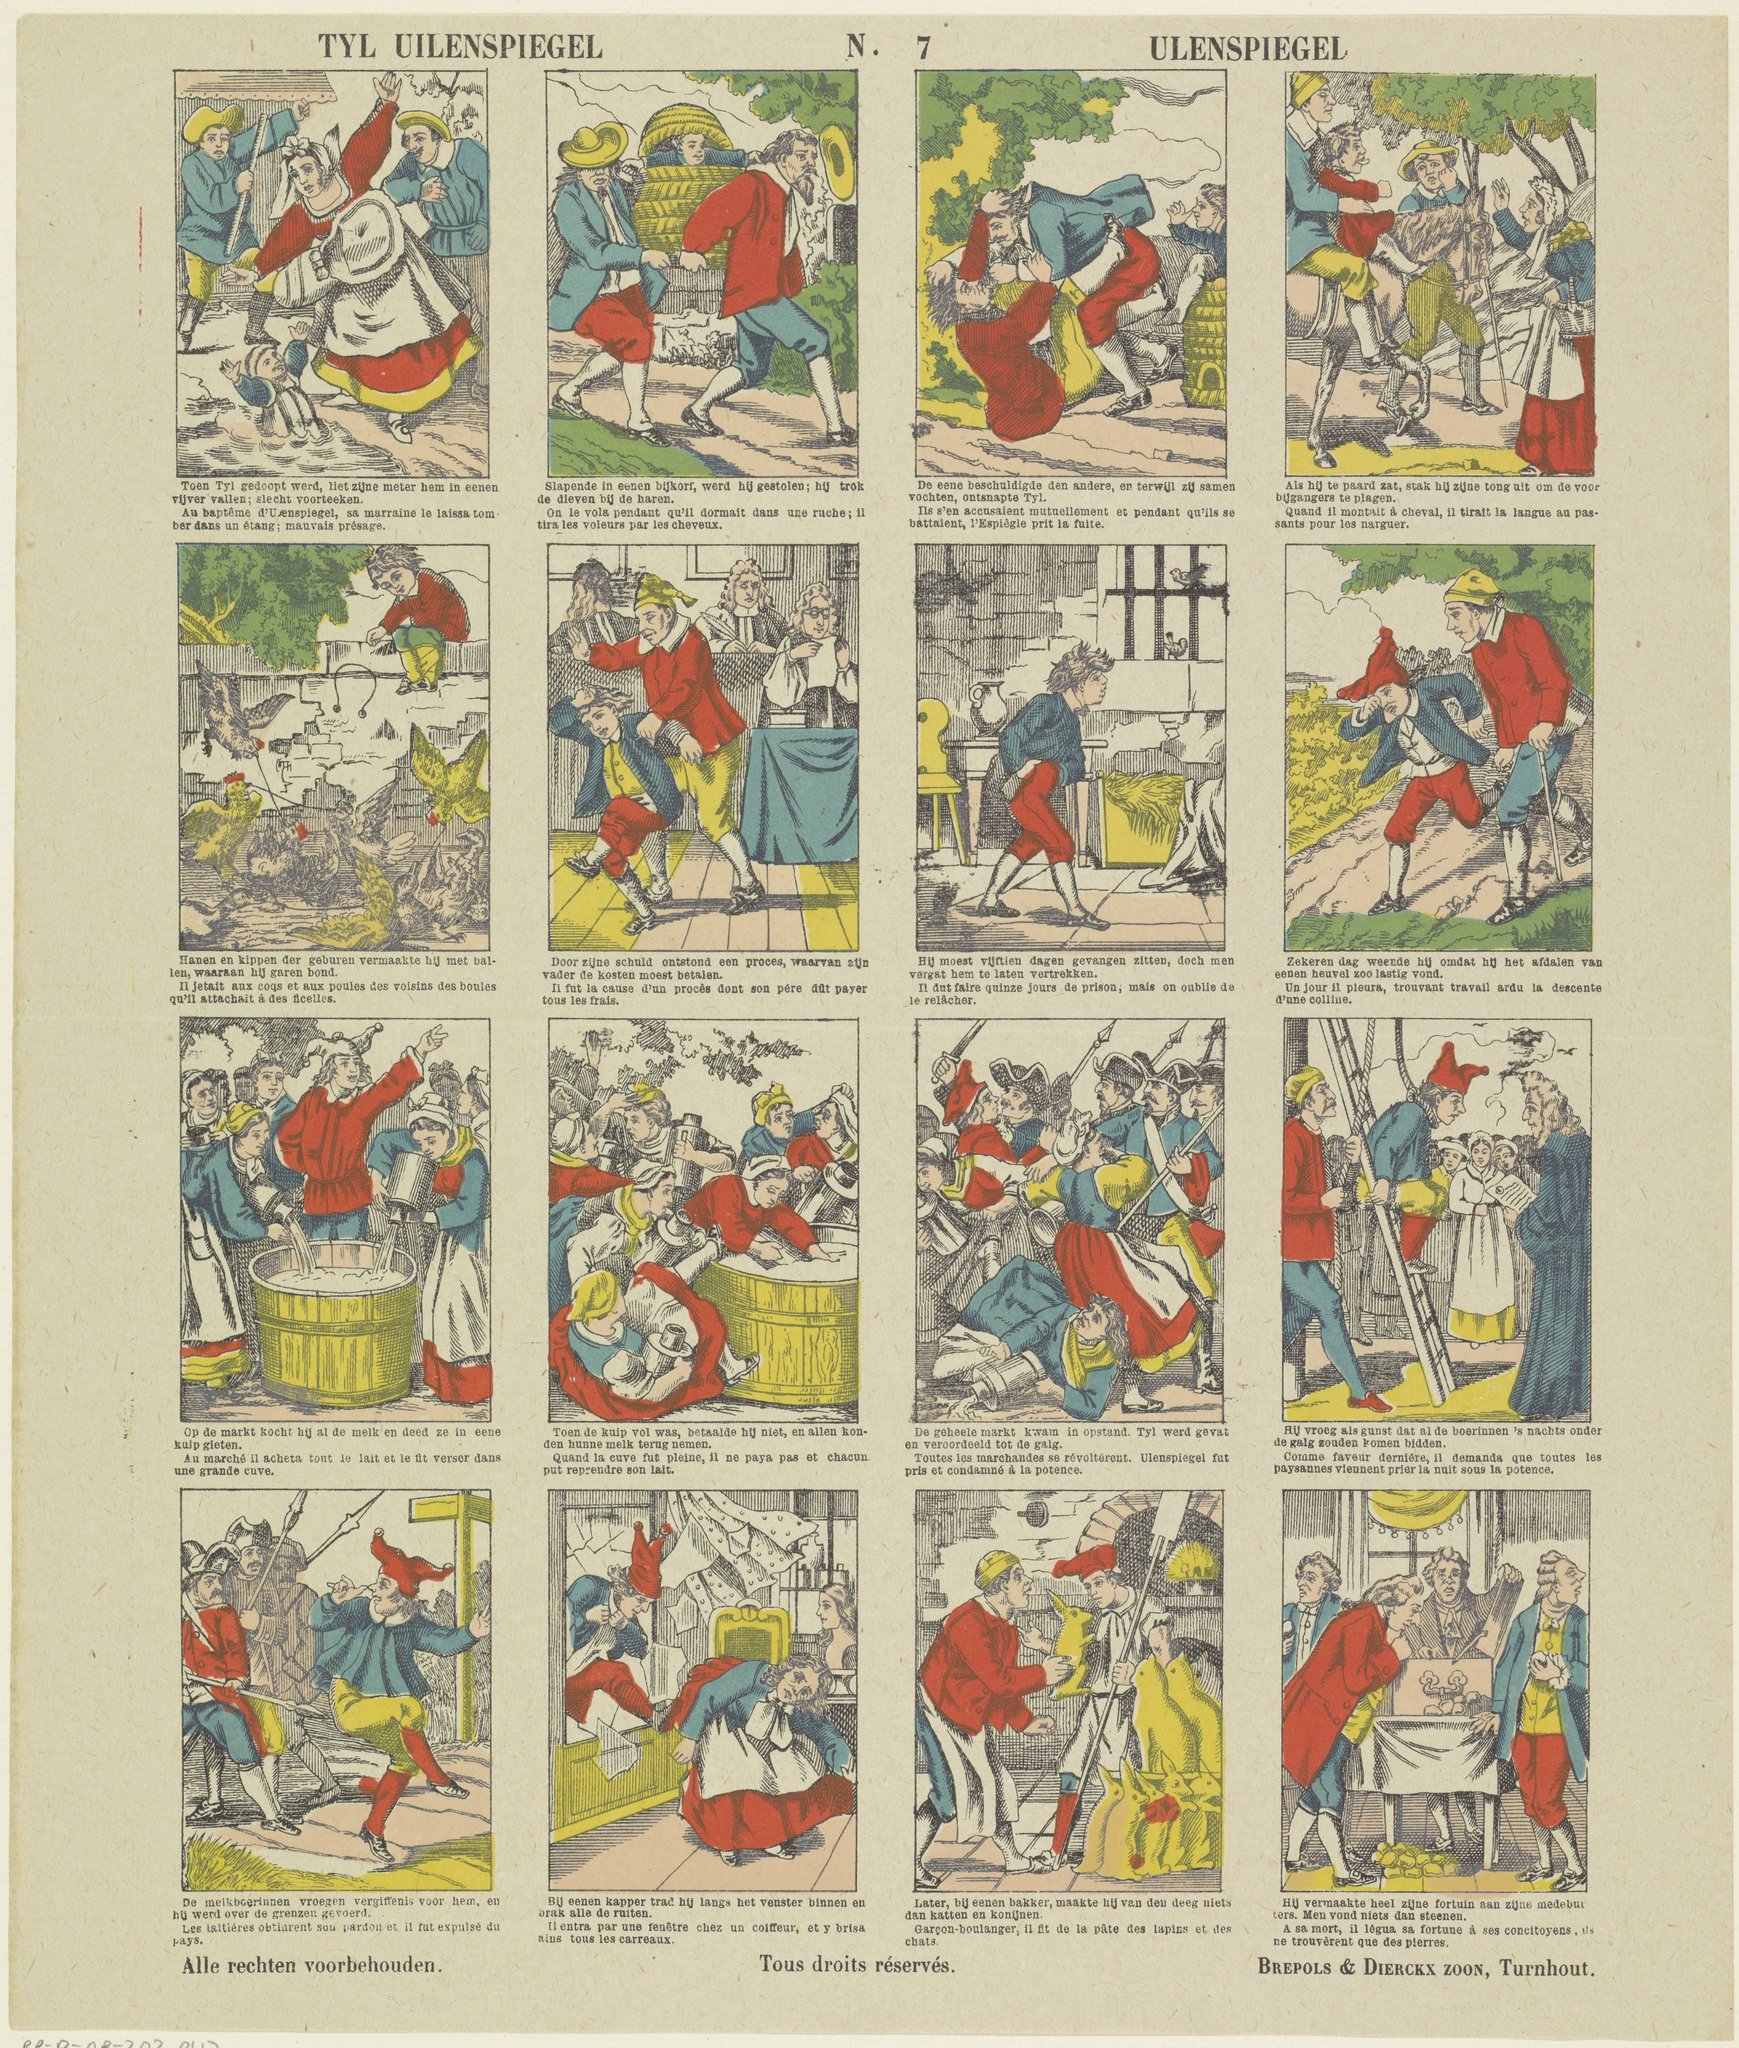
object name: popular print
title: Tyl Uilenspiegel / Ulenspiegel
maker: Anonymous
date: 1833-1911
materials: paper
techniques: lithograph, letterpress printing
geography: turnhout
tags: eulenspiegel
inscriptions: collector's mark: Lugt 2760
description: Blad met 16 voorstellingen over het leven van Tijl Uilenspiegel. Onder elke afbeelding een onderschrift in het Nederlands en in het Frans. Genummerd midden boven: N. 7.